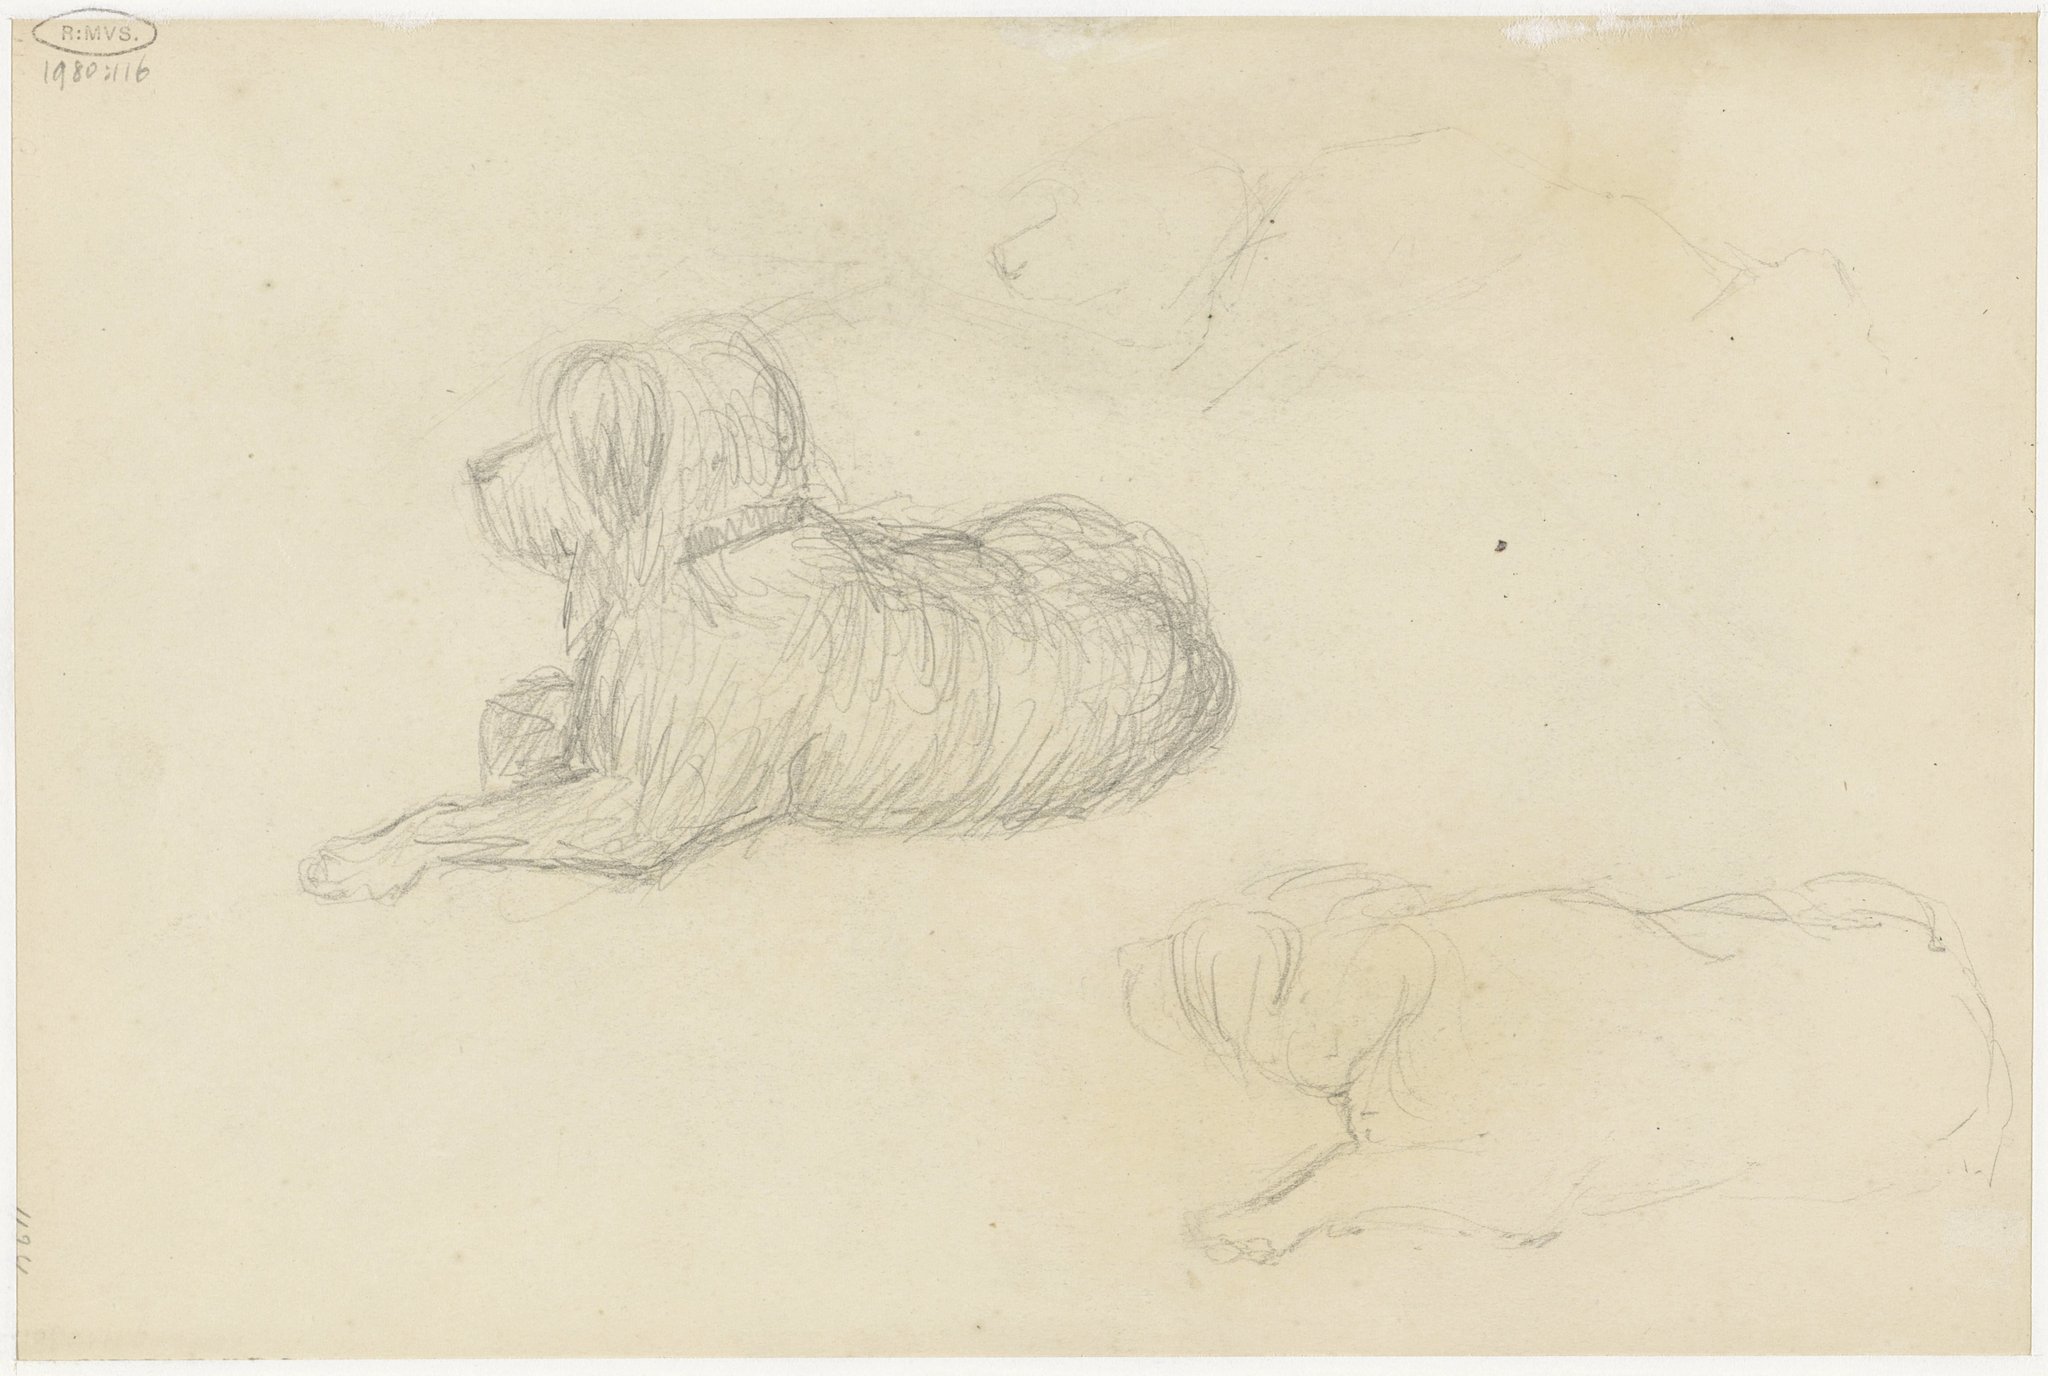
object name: drawing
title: Twee studies van een hond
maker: jozef israëls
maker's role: draughtsman, painter, print maker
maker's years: 1824-1911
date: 1834-1911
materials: paper, pencil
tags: dog